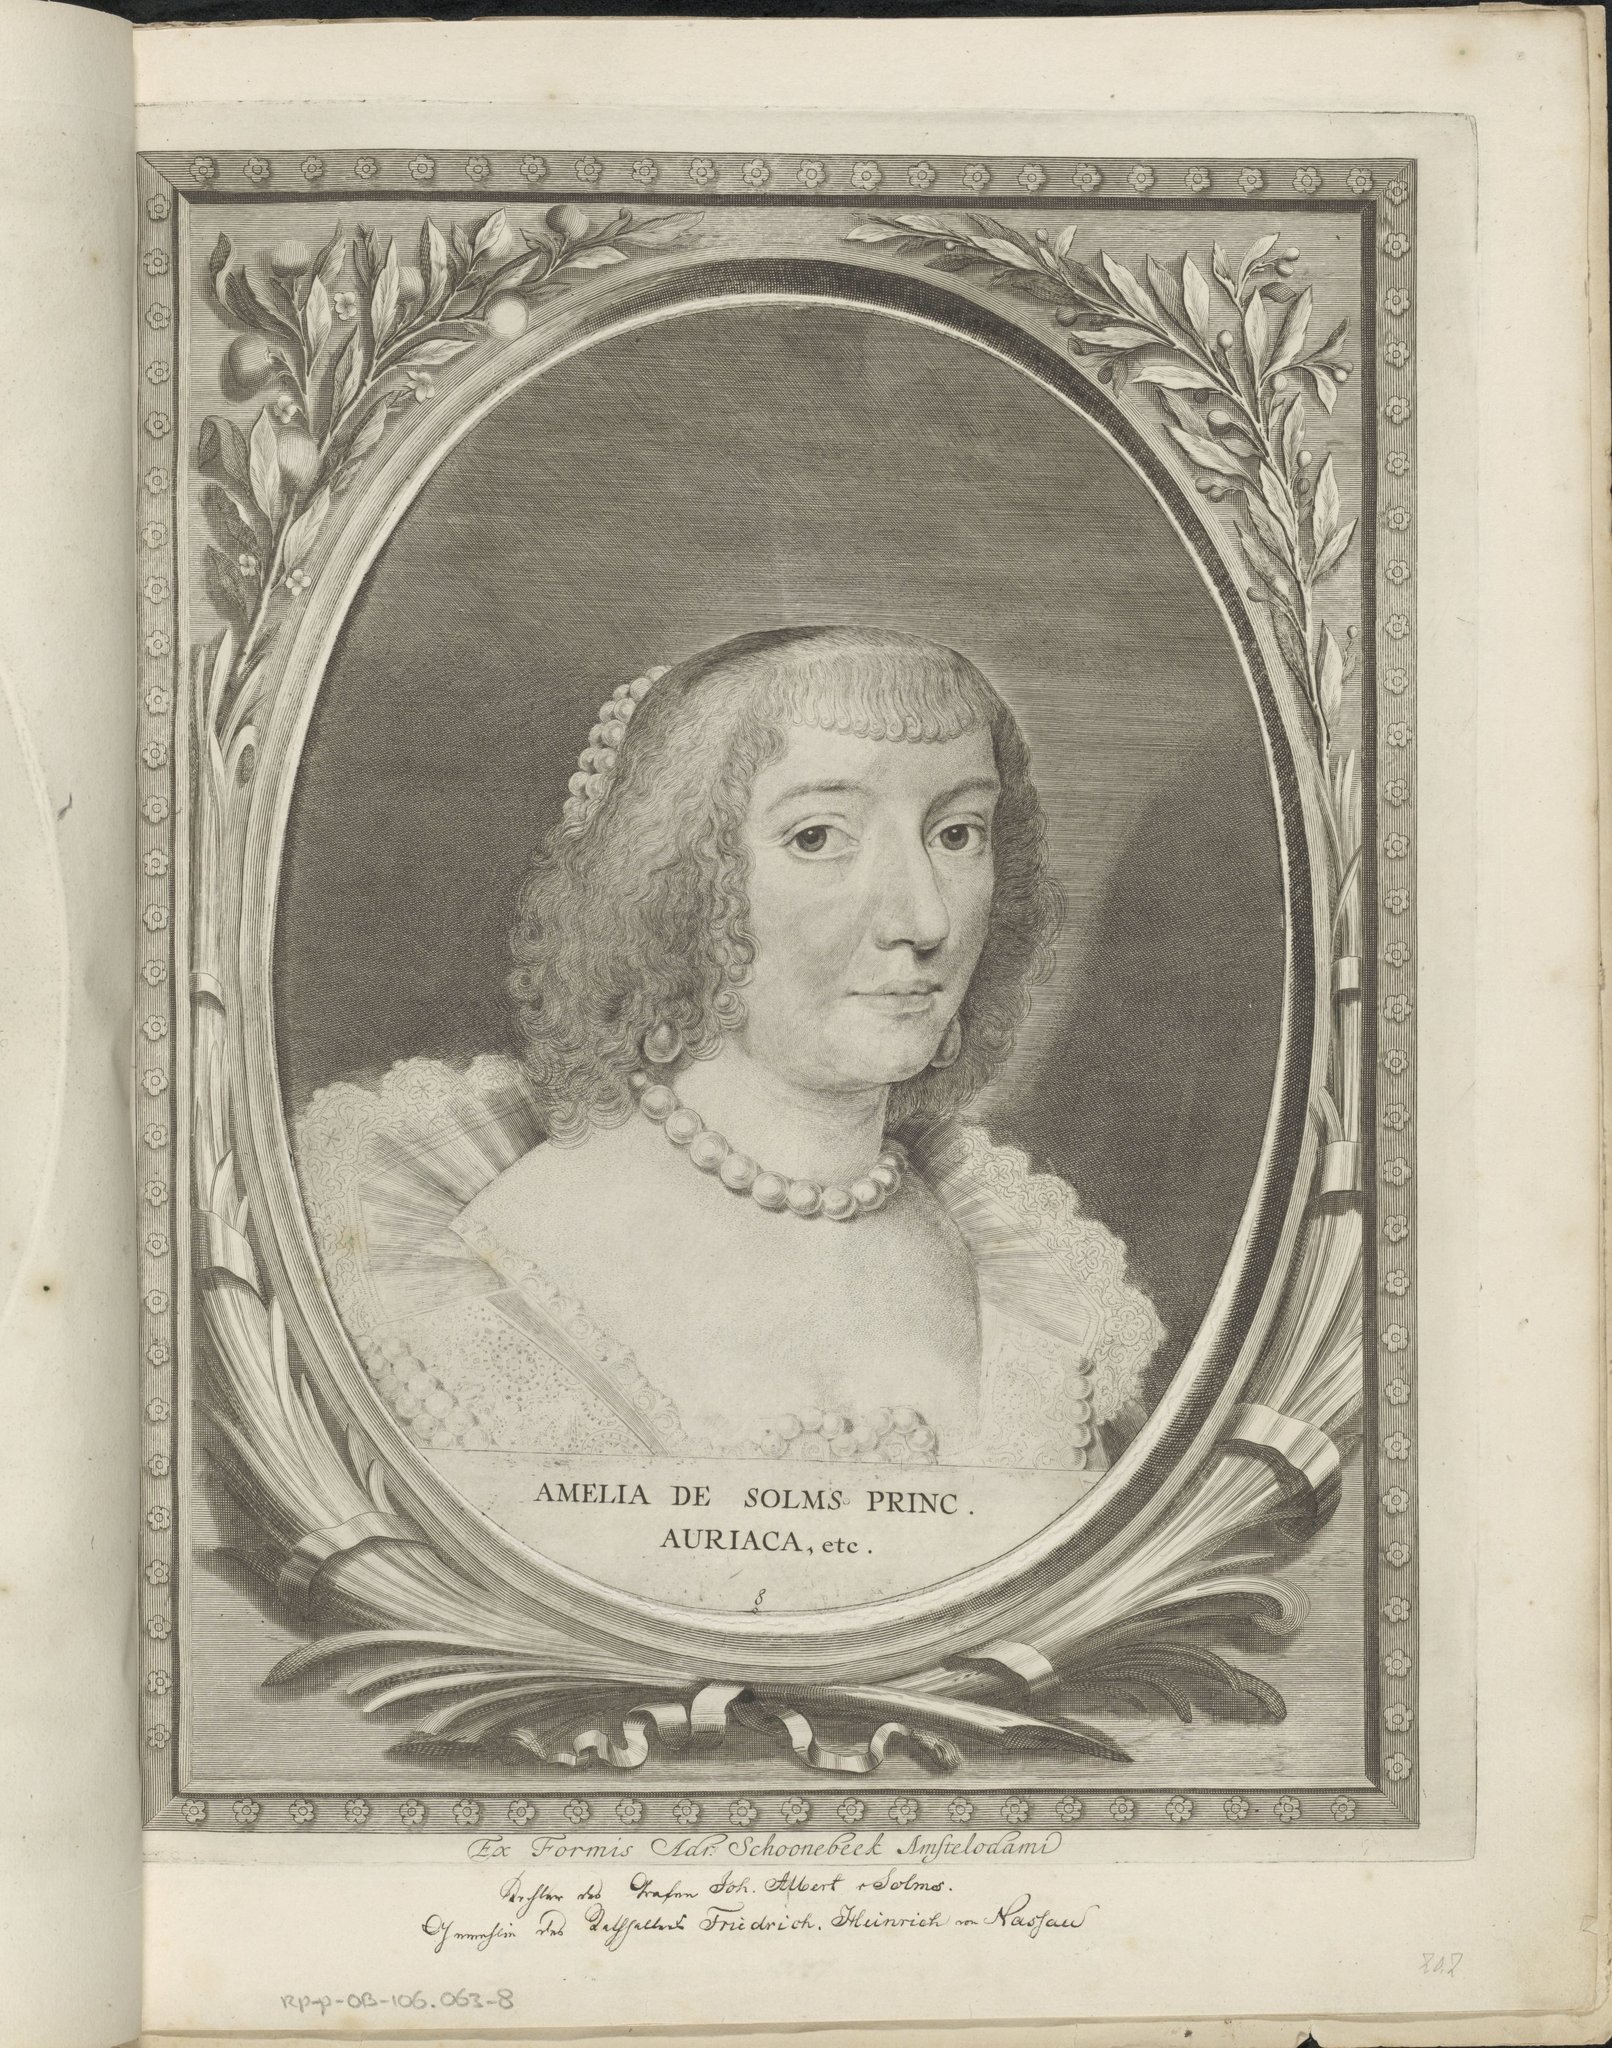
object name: print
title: Comites Nassoviae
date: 1689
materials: paper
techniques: engraving, etching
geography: haarlem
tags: amalia of solms-braunfels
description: Portret van Amalia. In een kader haar naam en titels. Geheel in een afzonderlijk gegraveerde ovale omlijsting met takken en linten.